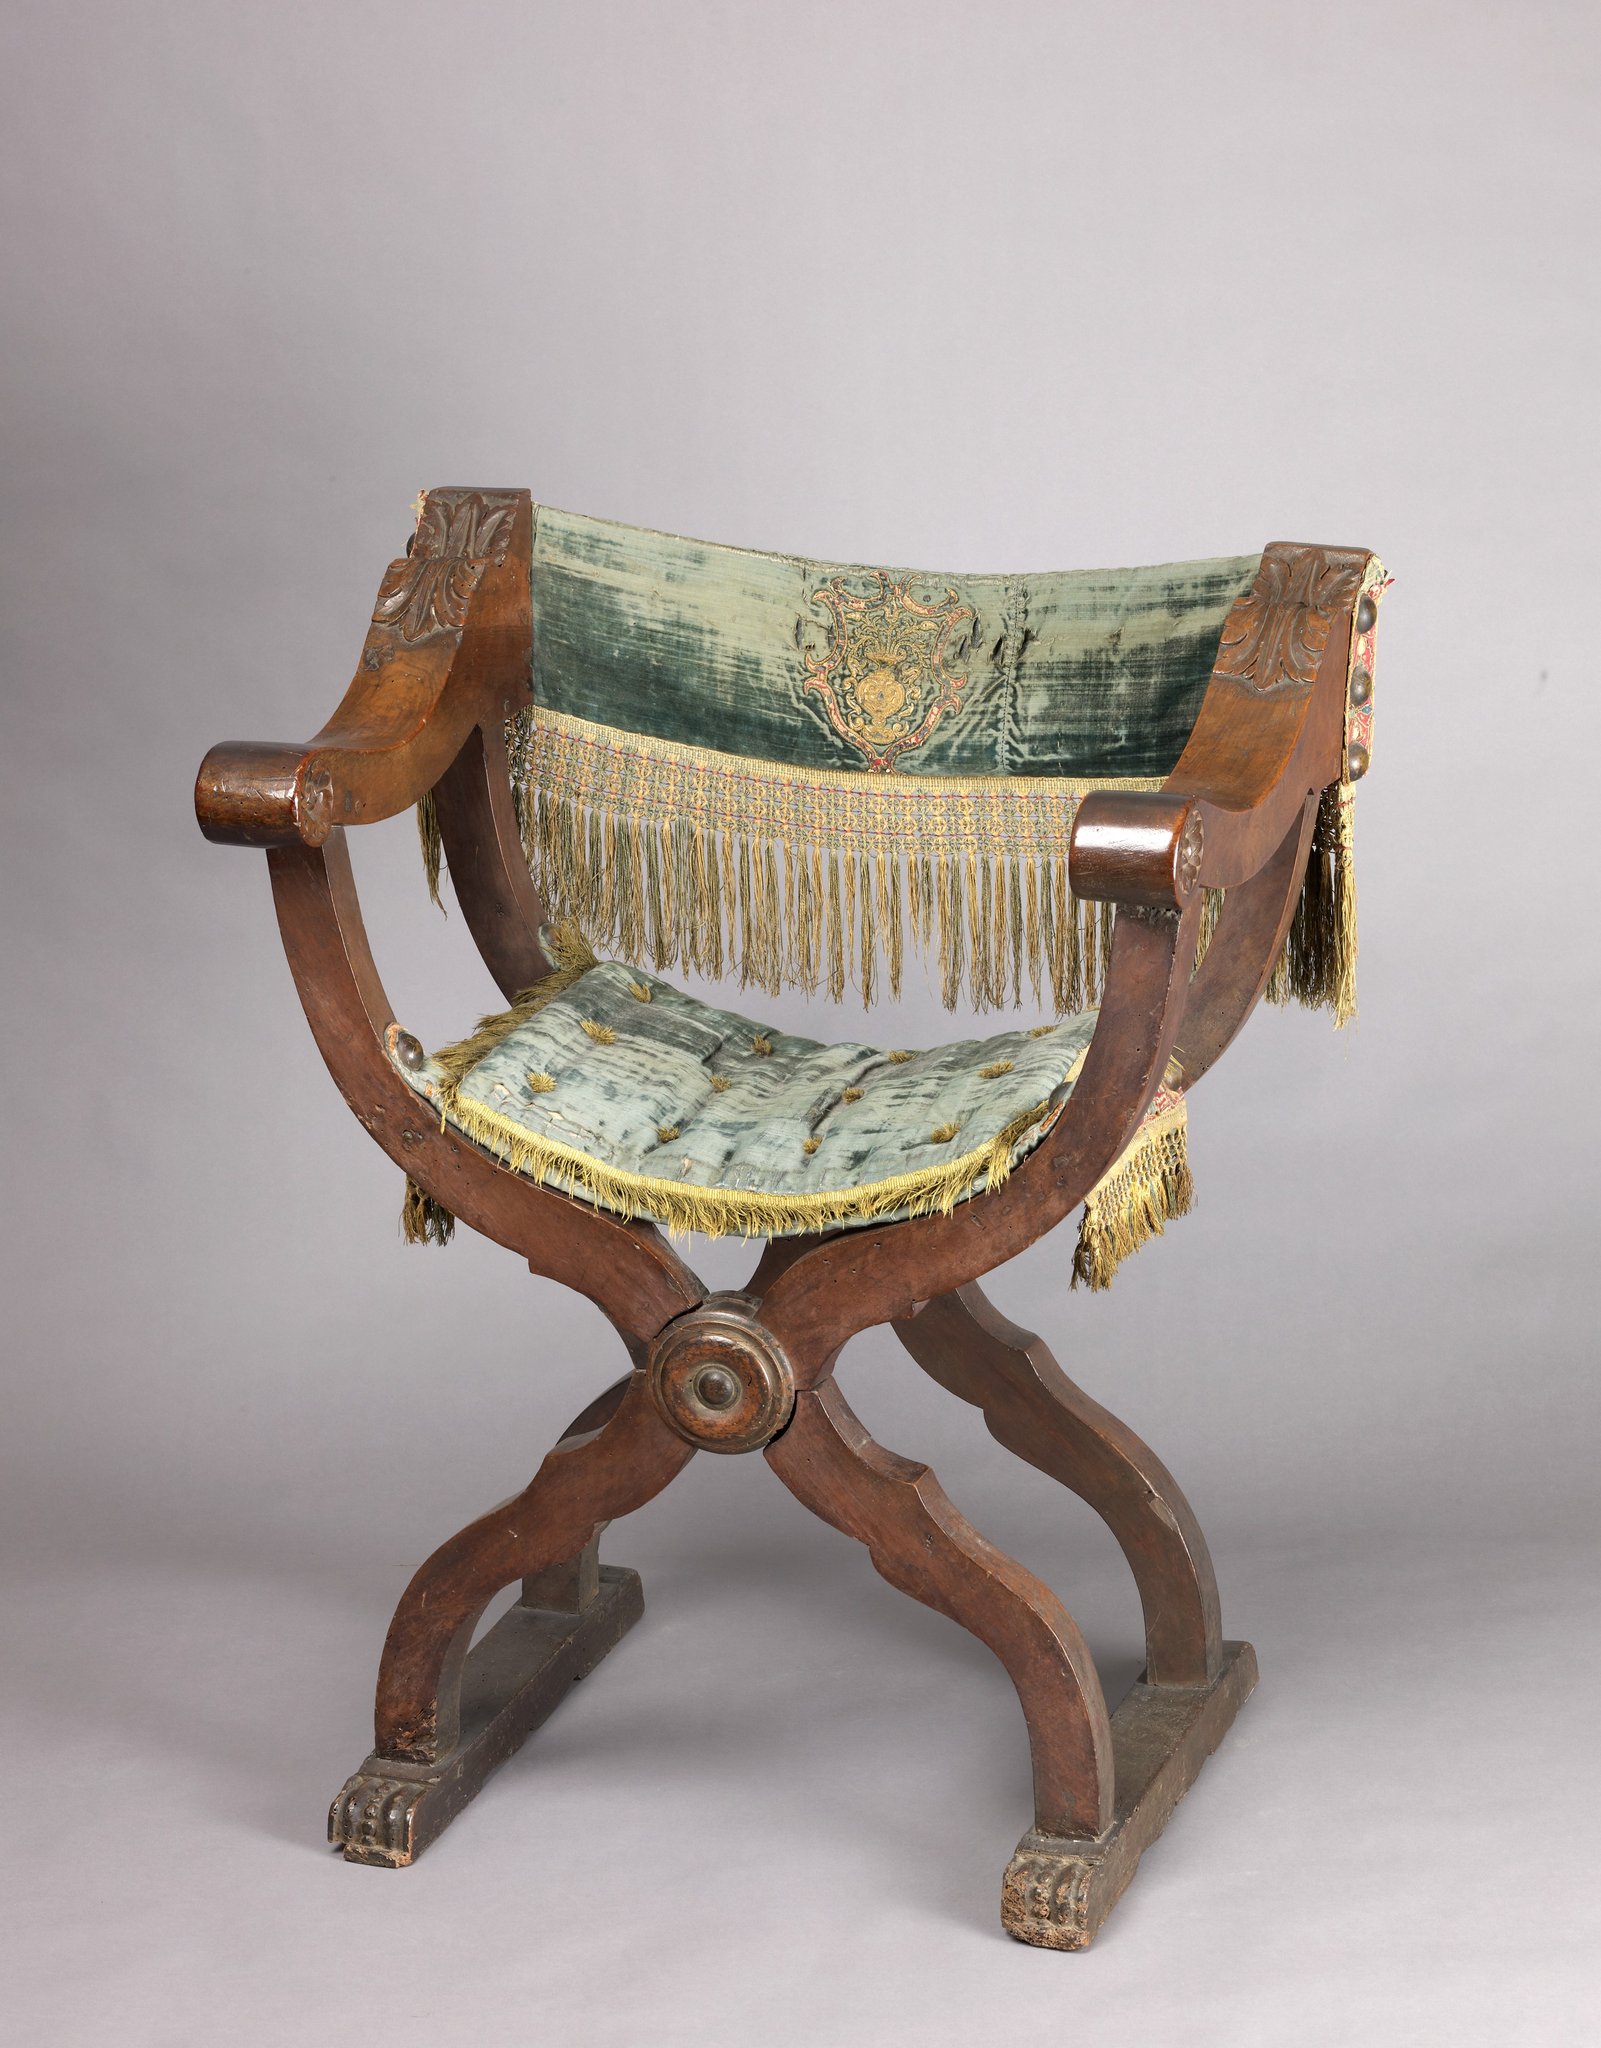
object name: armchair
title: Hip-joint armchair (Dantesca type, associated with 1975.1.1970 a,b)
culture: italian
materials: metal, silk, velvet, wood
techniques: carving, embroidery